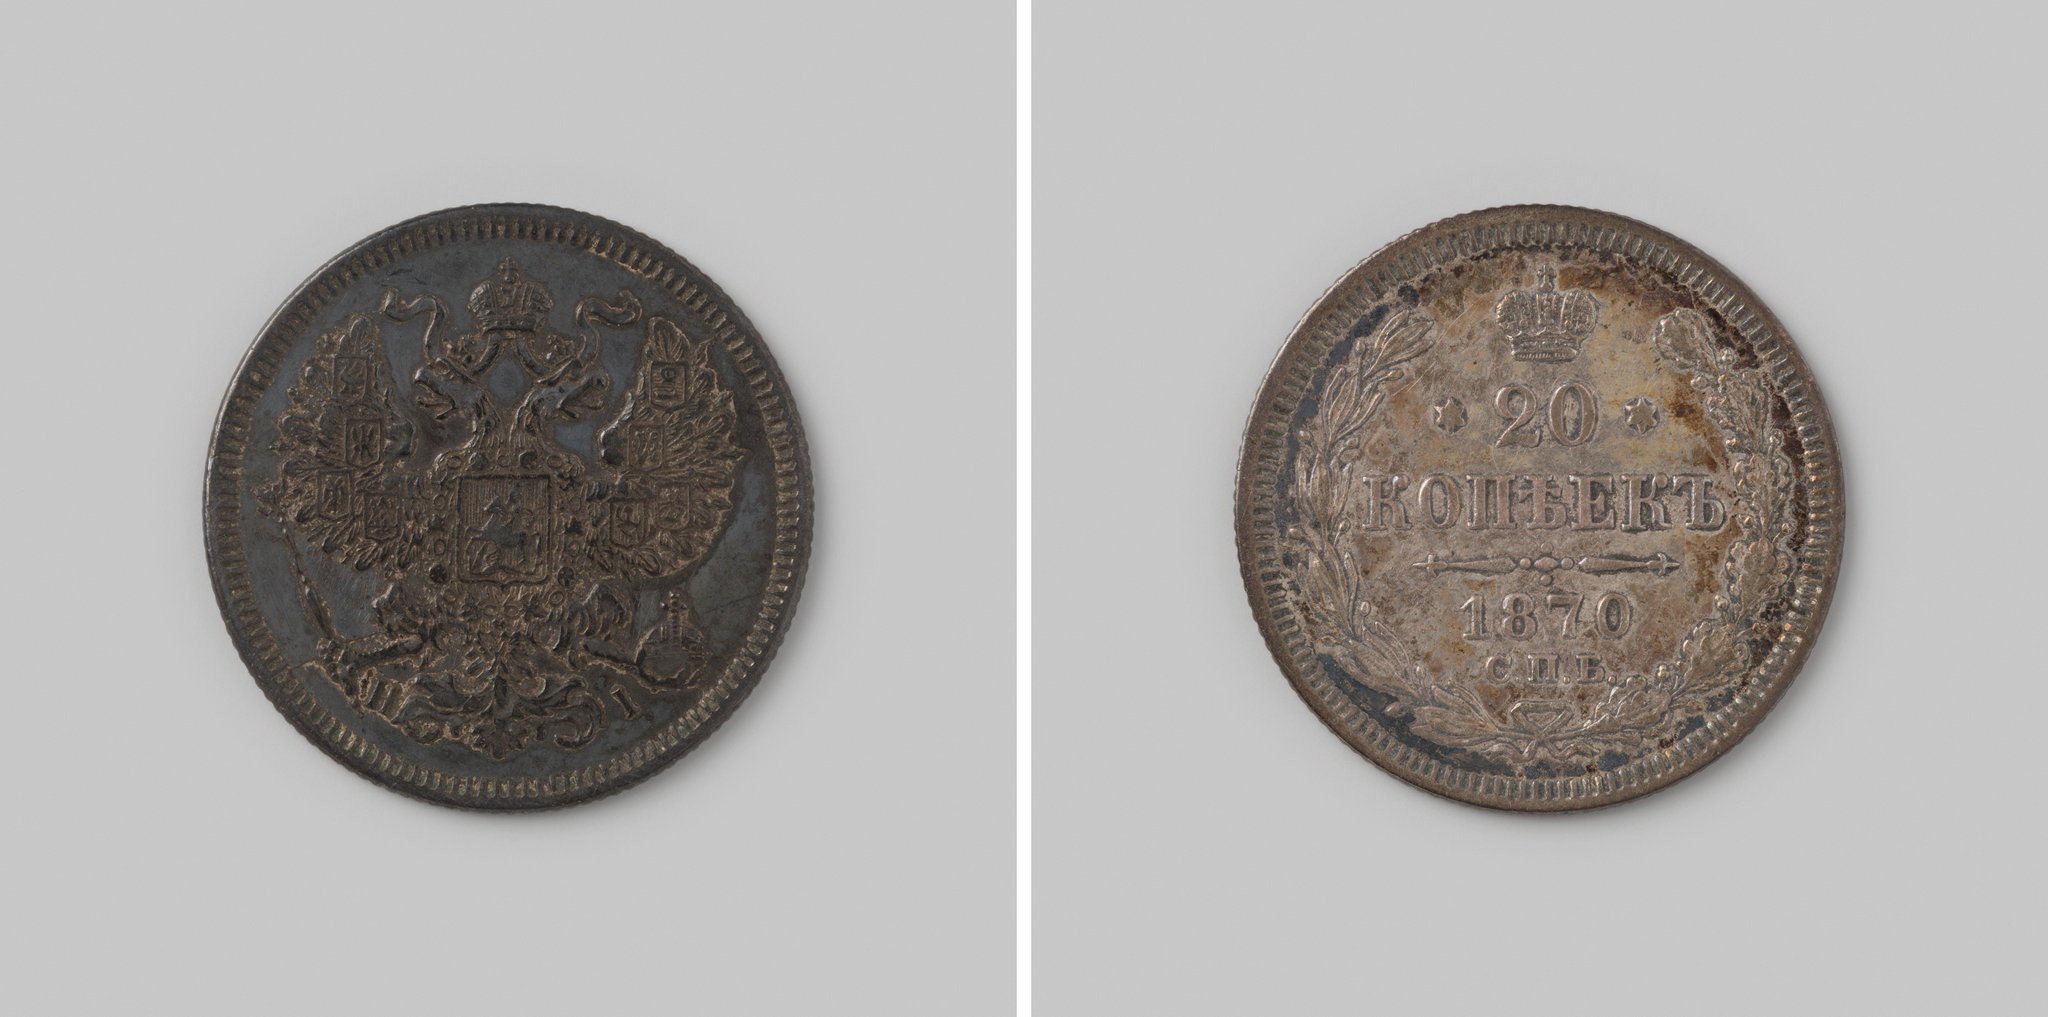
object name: coin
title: 20 kopeken uit Rusland van tsaar Alexander II, 1870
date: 1870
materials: silver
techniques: striking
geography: sint-petersburg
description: Zilveren munt. Voorzijde: dubbelkoppige gekroonde adelaar met gespreide vleugels en met op zijn vleugels kleine wapenschilden en op zijn borst een groot, met een ridderorde omhangen wapenschild en in zijn poten een scepter en een gekroonde bol. Boven de adelaar een kroon met lint. Keerzijde: tussen twee samengebonden takken een kroon, waaaronder in twee regels de waarde-aanduiding. Daaronder jaartal, waaronder in het Cyrillisch de letters S,P en B [=Sint Petersburg]. Kartelrand.